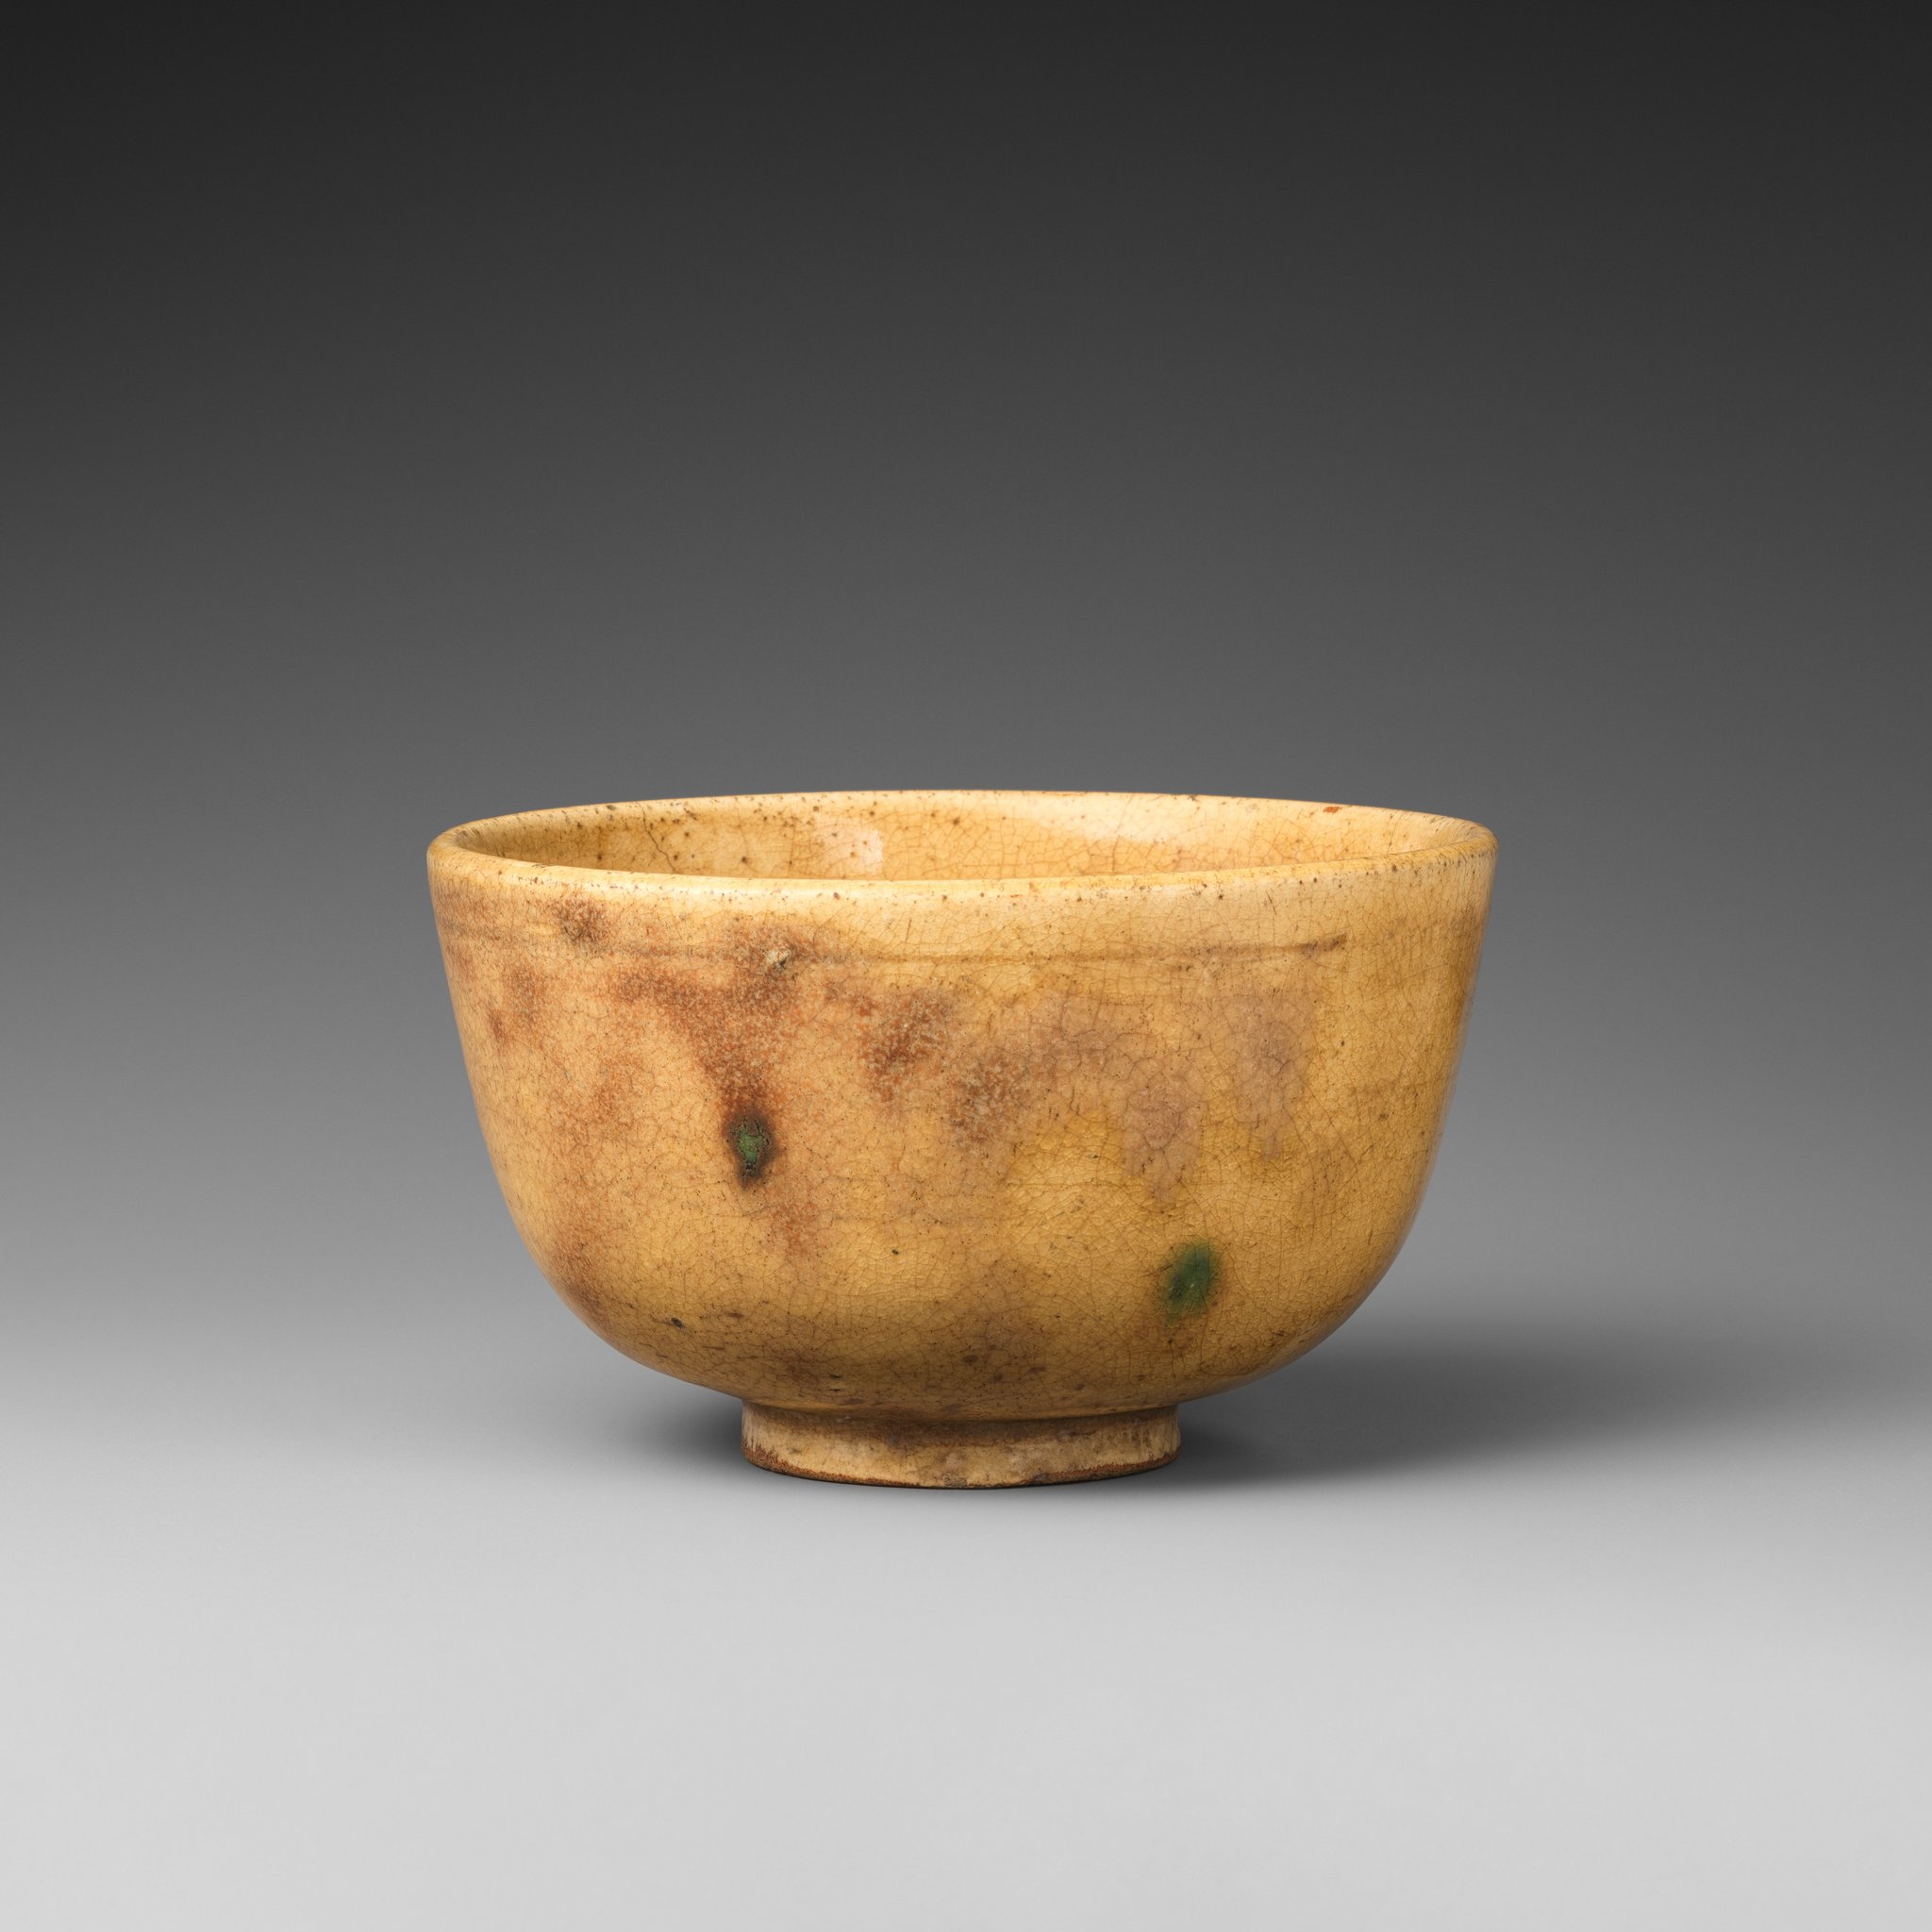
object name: bowl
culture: japanese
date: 1501-1600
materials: glaze, pottery